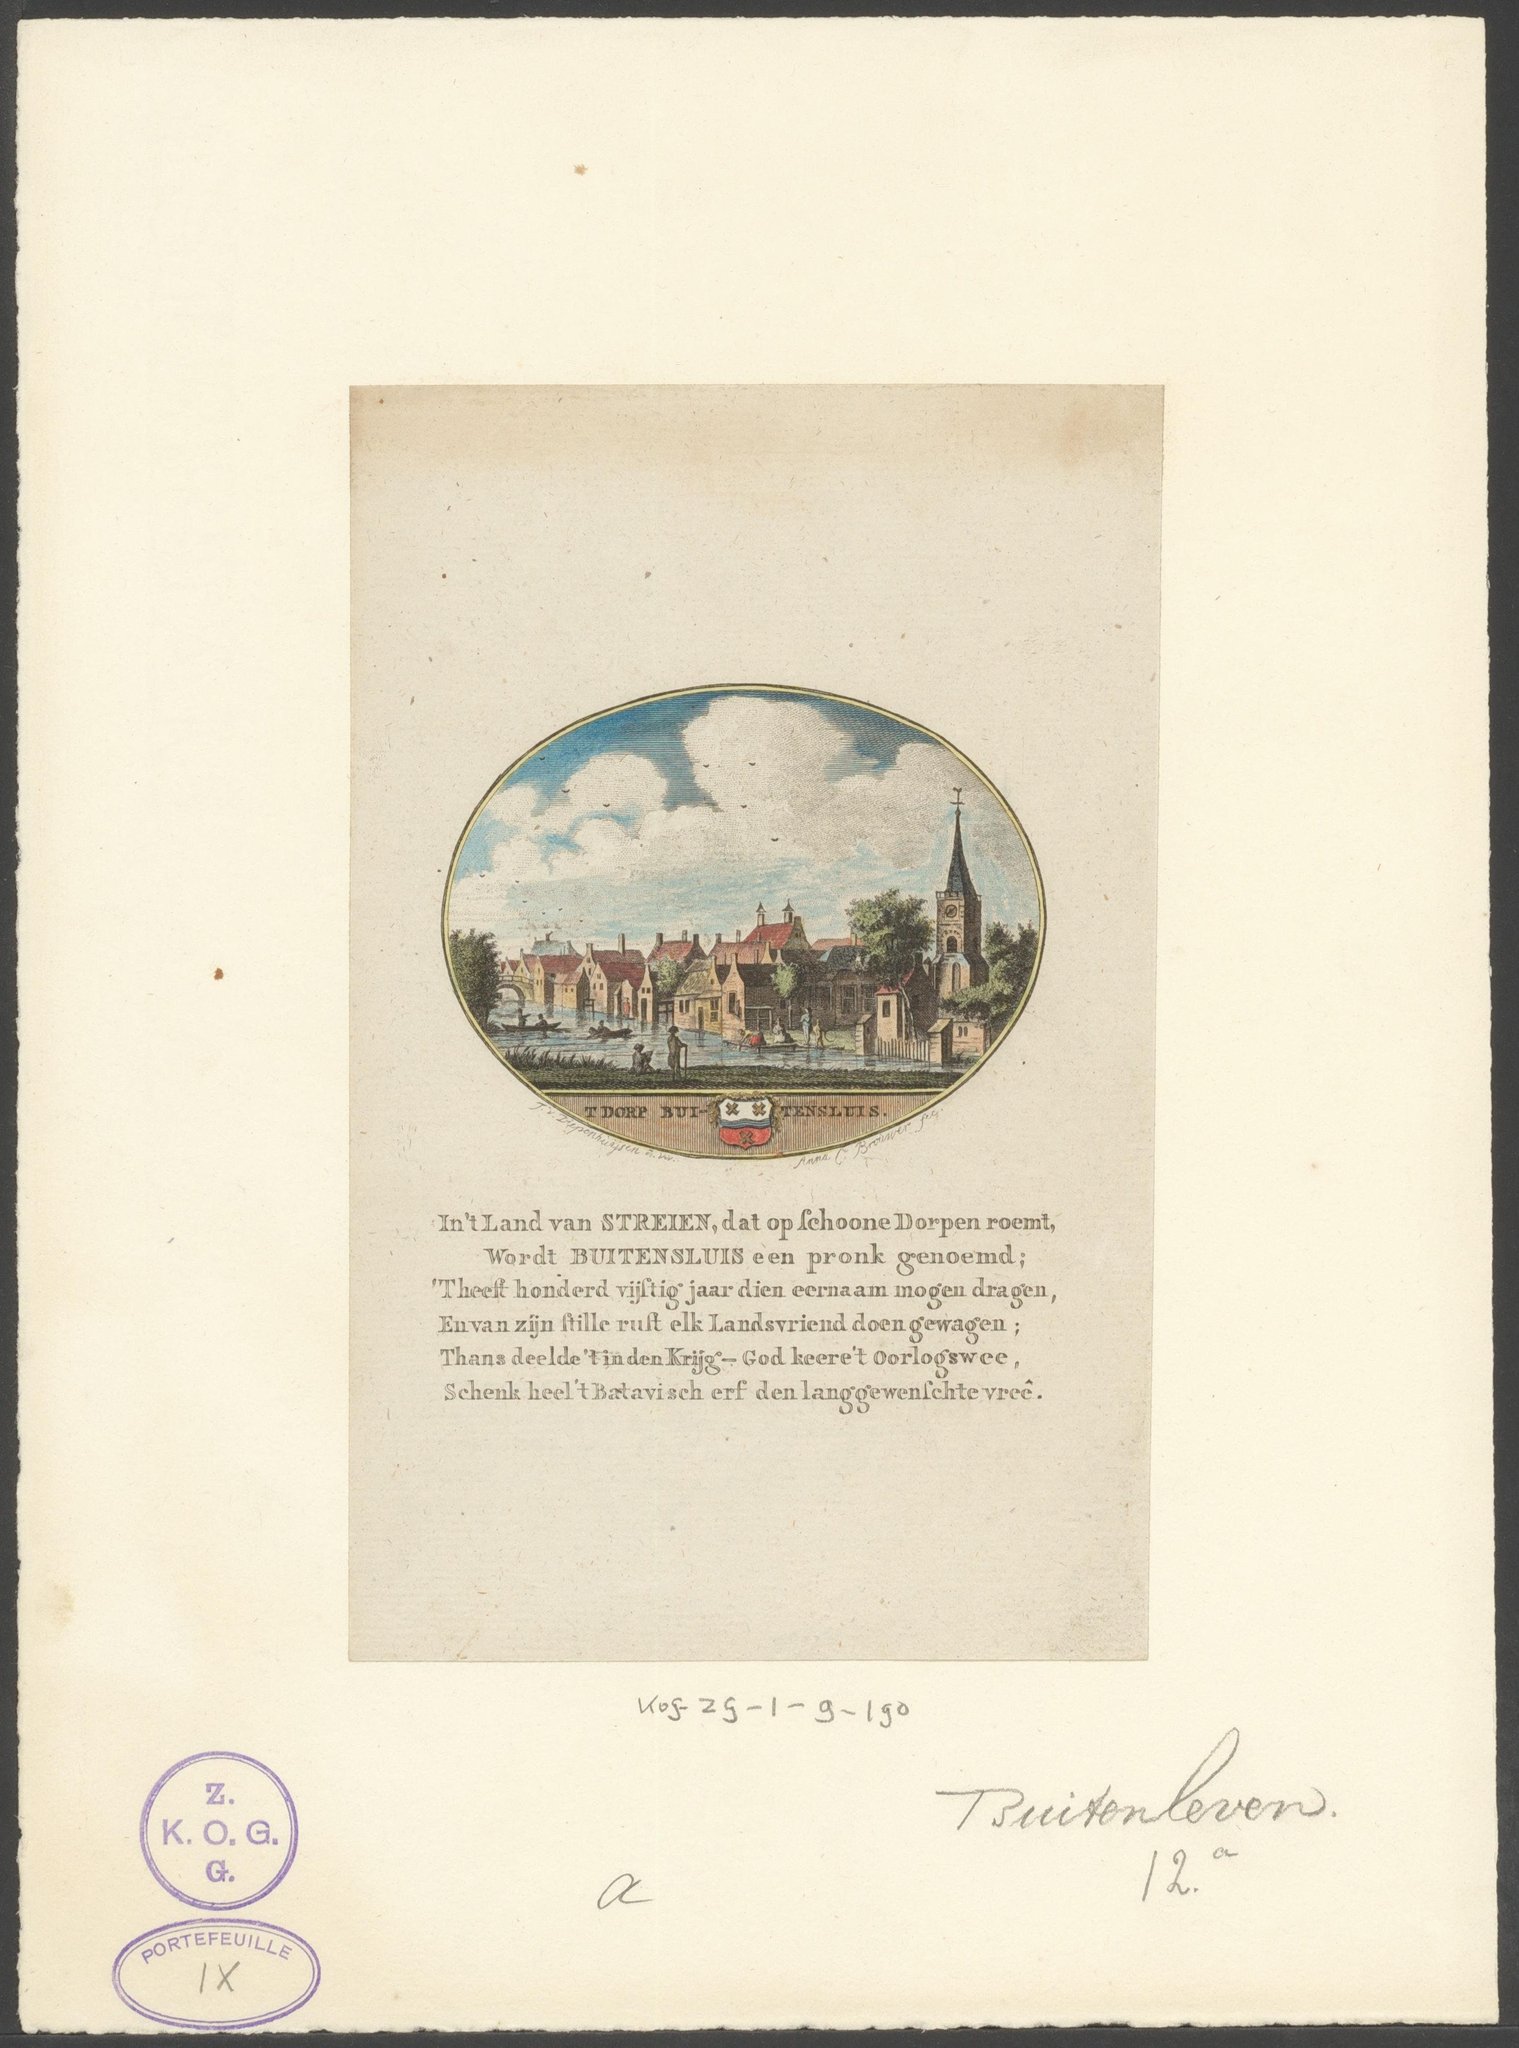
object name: print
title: T Dorp Buitensluis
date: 1791-1793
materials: paper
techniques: etching, hand coloring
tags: city-view, and landscape with man-made constructions, canal, church (exterior)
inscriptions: stamp, collector's mark: Lugt 1641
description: Gezicht op Numansdorp. Onderaan een zesregelig vers. Onderwerpsrubrieken binnen de Atlas Zeden en Gewoonten: Handel, nijverheid en verkeer, Buitenleven.